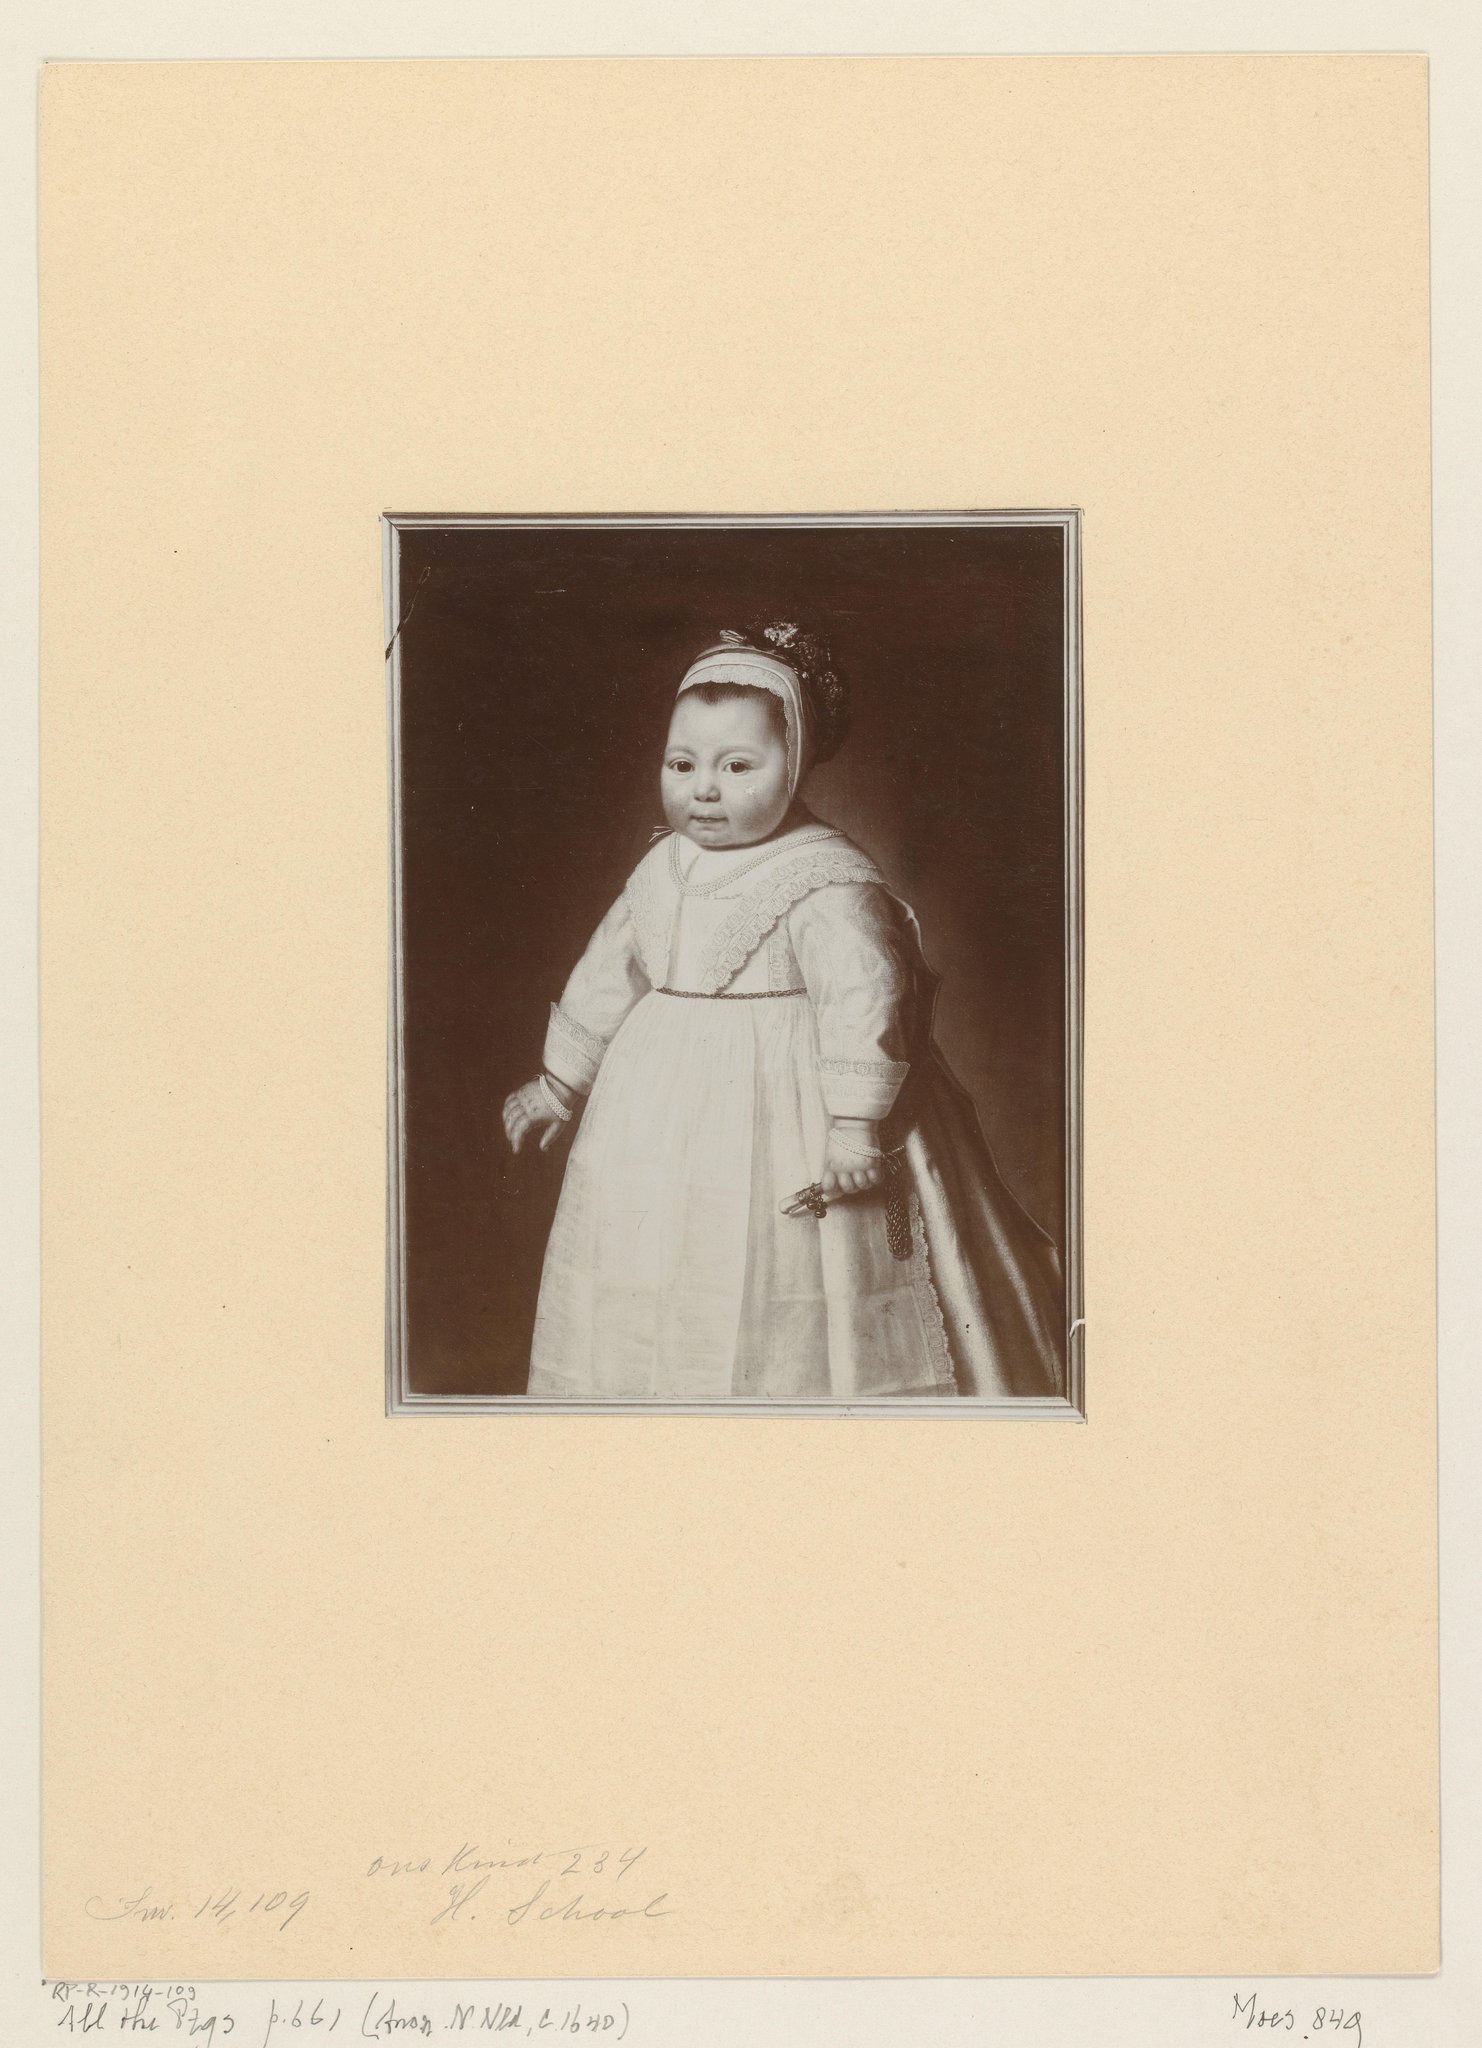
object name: reproduction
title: Fotoreproductie van een geschilderd portret van Jacoba Bontemantel als kind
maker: Anonymous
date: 1885-1914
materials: paper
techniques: gelatin silver print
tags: historical persons - bb - woman, girl (child between toddler and youth)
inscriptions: collector's mark: Lugt 2228